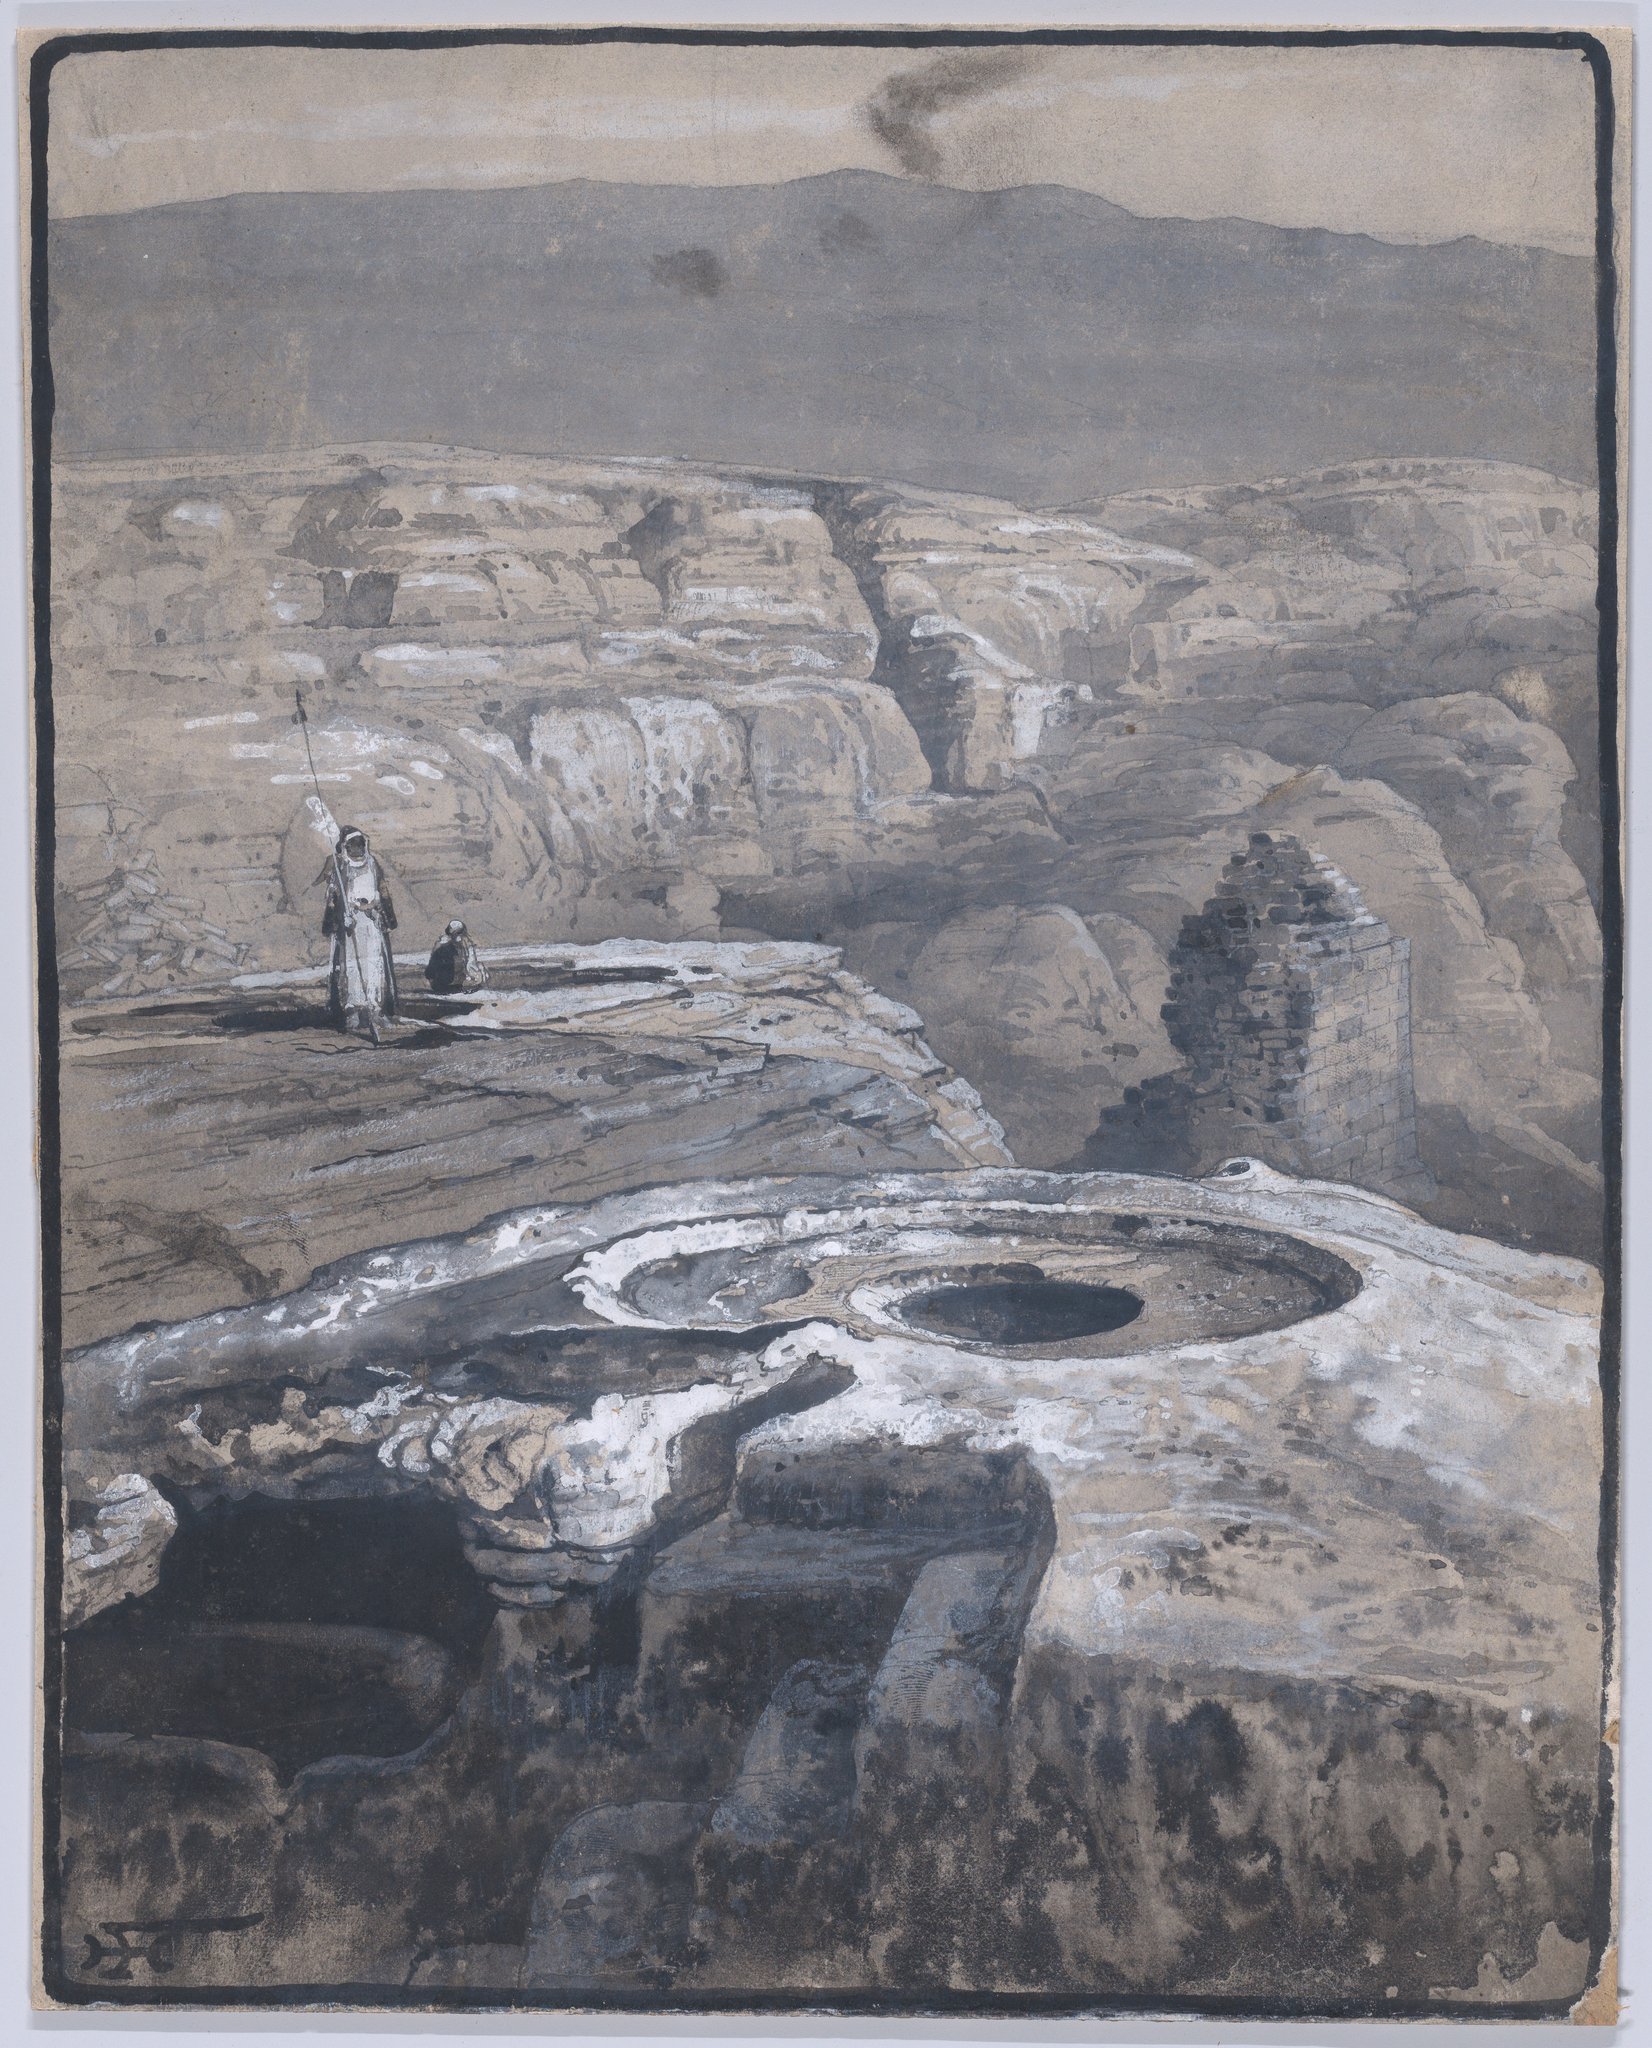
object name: drawing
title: The Altar of Baal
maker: harry fenn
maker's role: artist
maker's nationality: american, born england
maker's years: 1845-1911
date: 1885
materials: gouache, watercolor